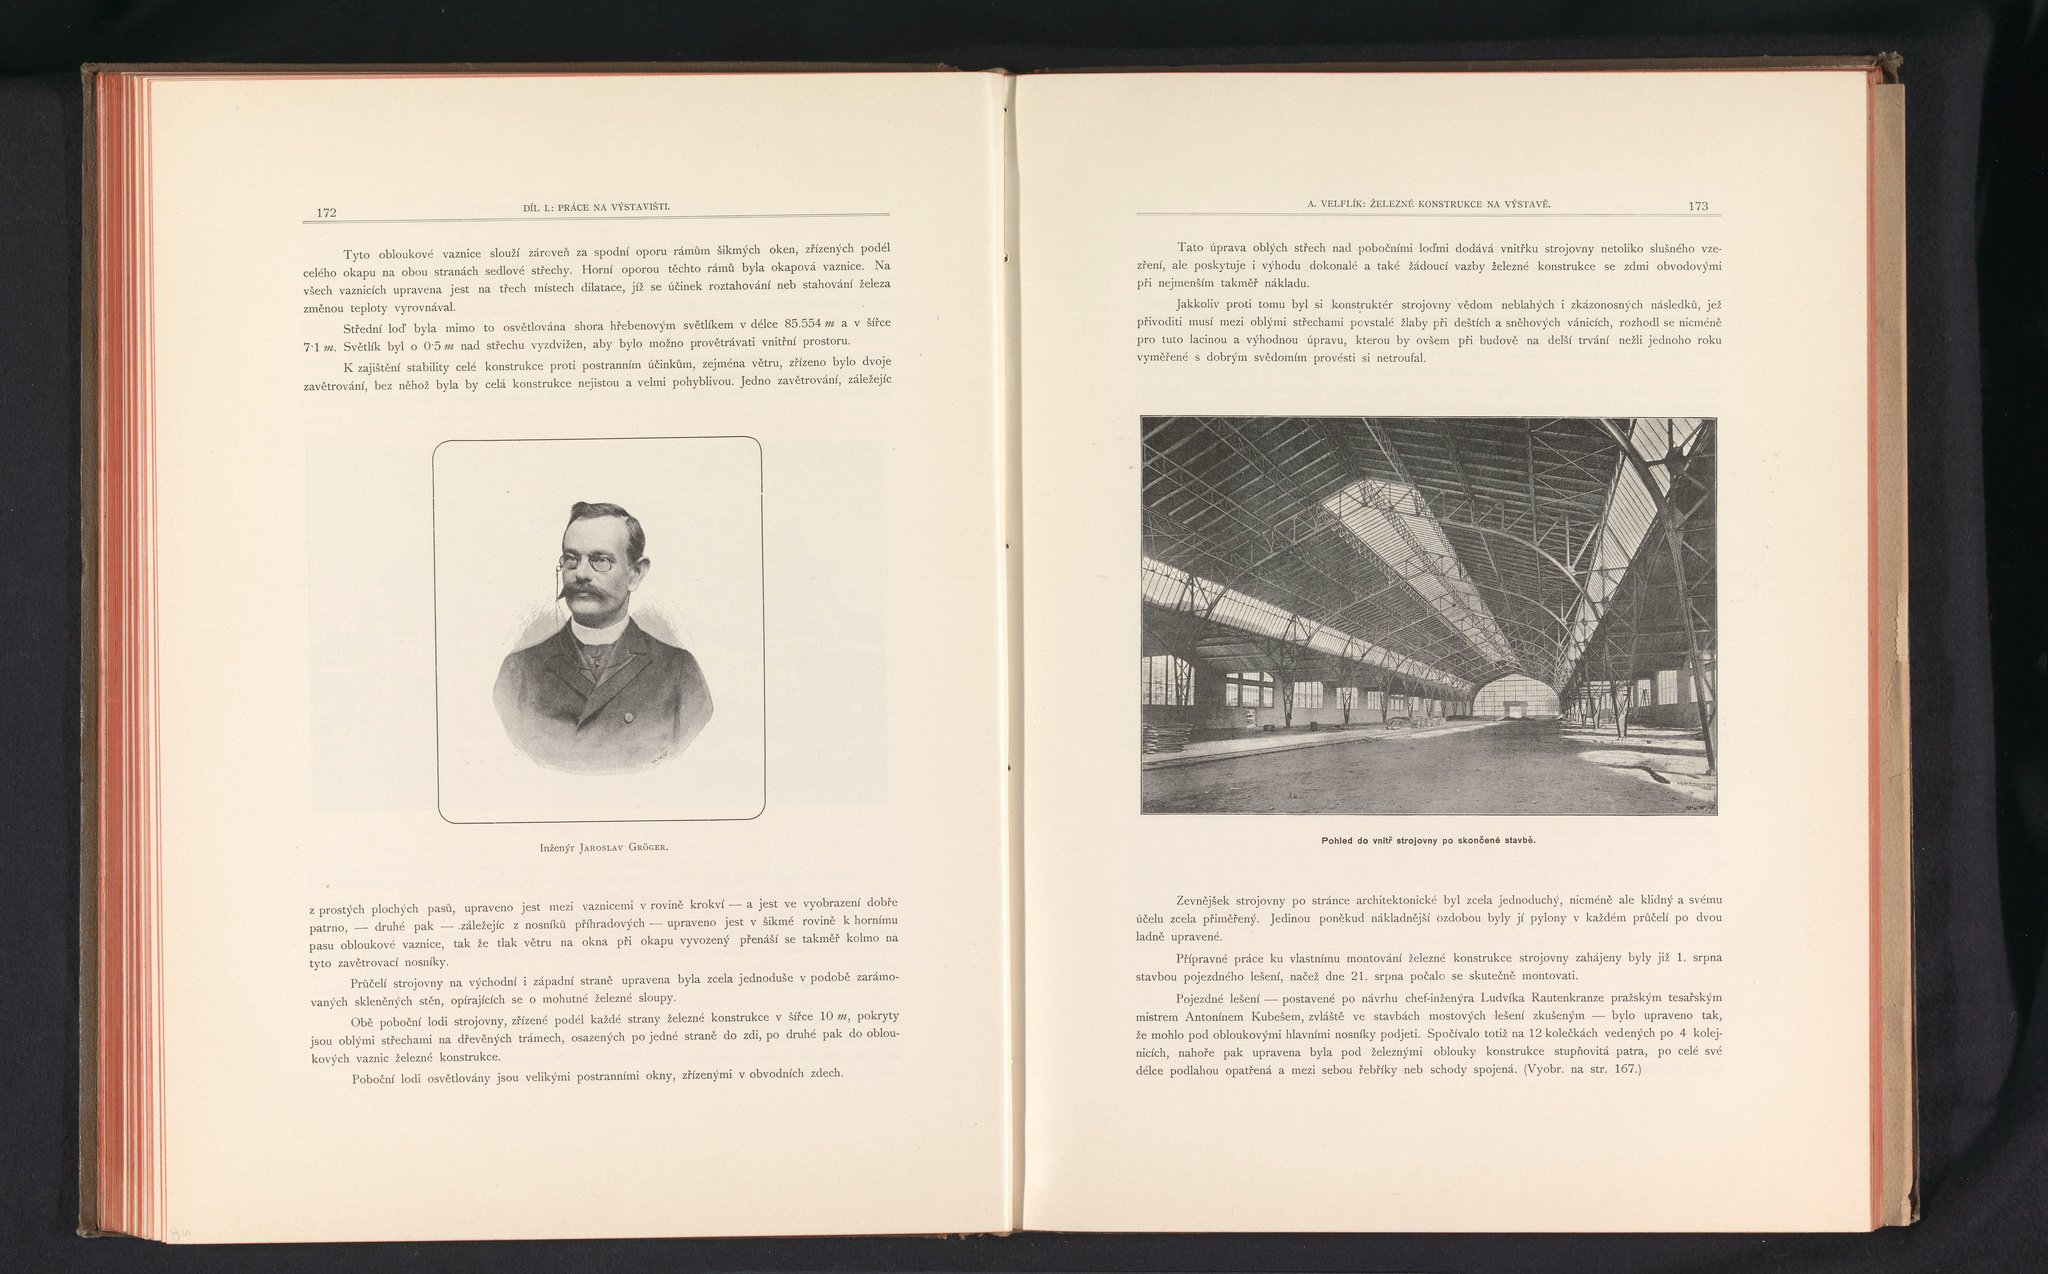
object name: photomechanical print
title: Gezicht op de machinekamer van een gebouw te Praag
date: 1888-1893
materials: paper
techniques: autotype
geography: prague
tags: building-site